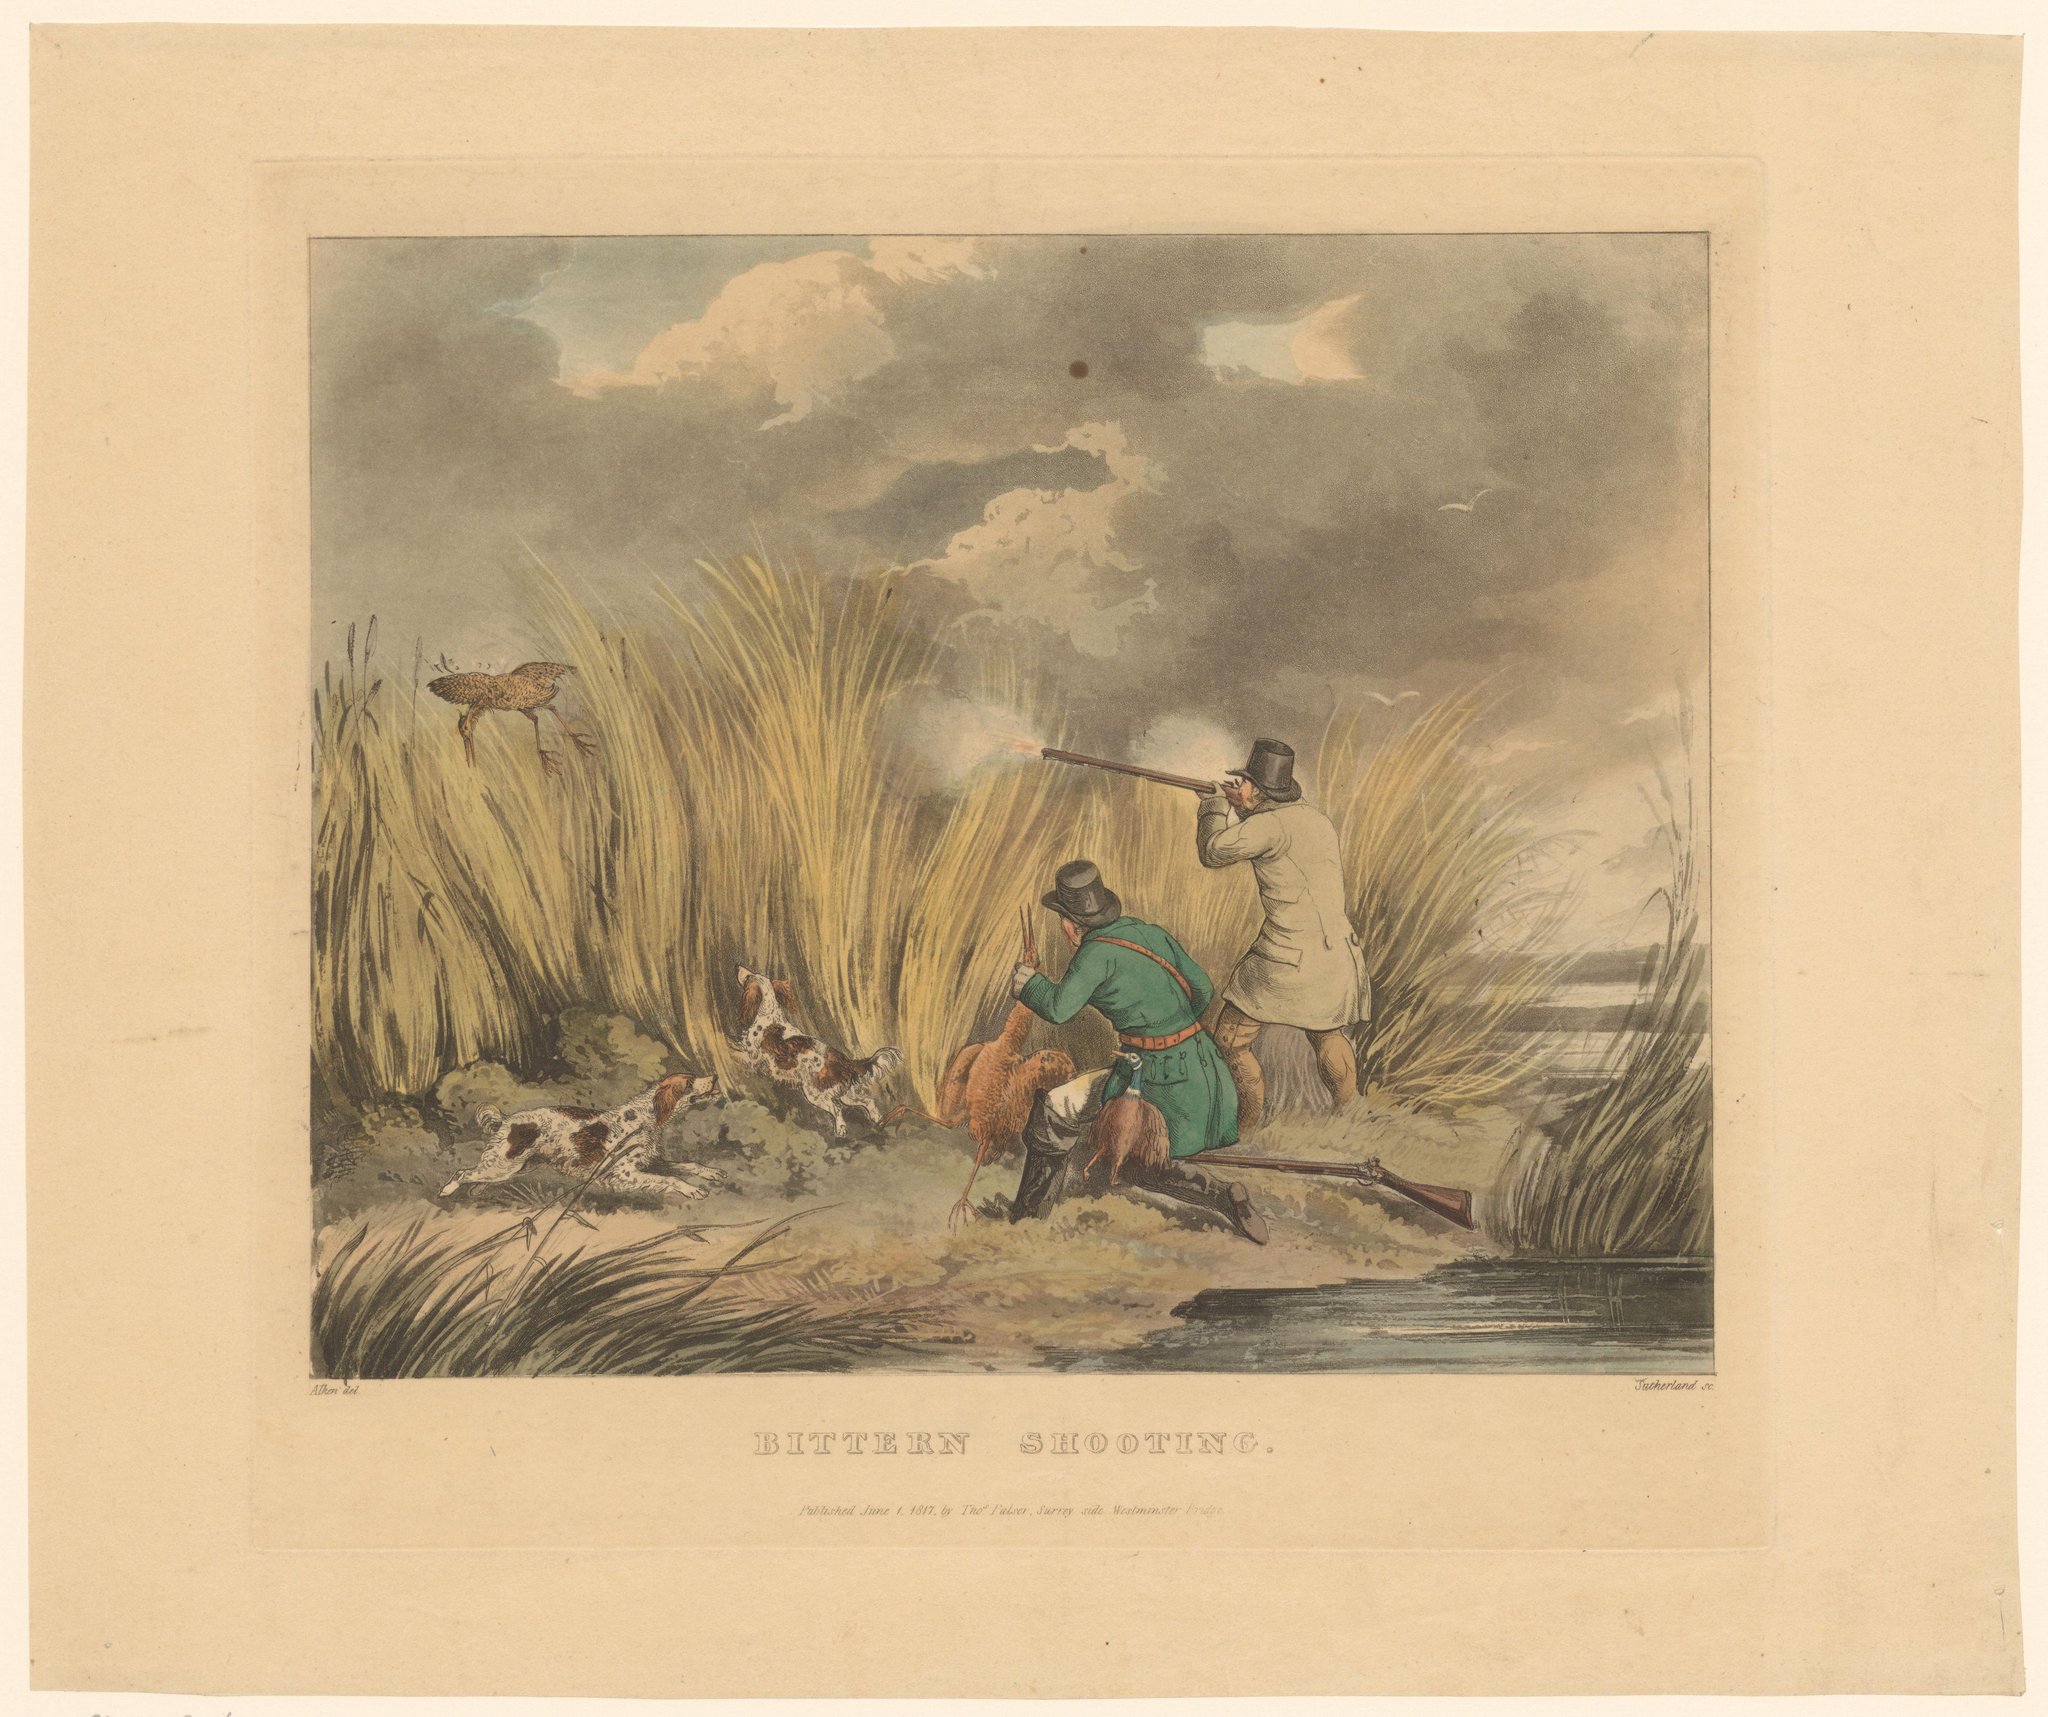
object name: print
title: Shooting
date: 1806-1817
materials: paper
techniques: etching, hand coloring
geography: london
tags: bird hunting, shore-birds and wading-birds: bittern, dog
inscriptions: collector's mark: Lugt 2233